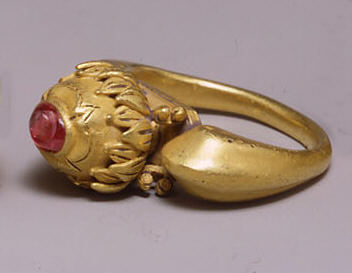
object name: ring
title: Stirrup-Shaped Ring with Red Stone in Circular Mount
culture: indonesian, javanese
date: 701-933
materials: gold, stone